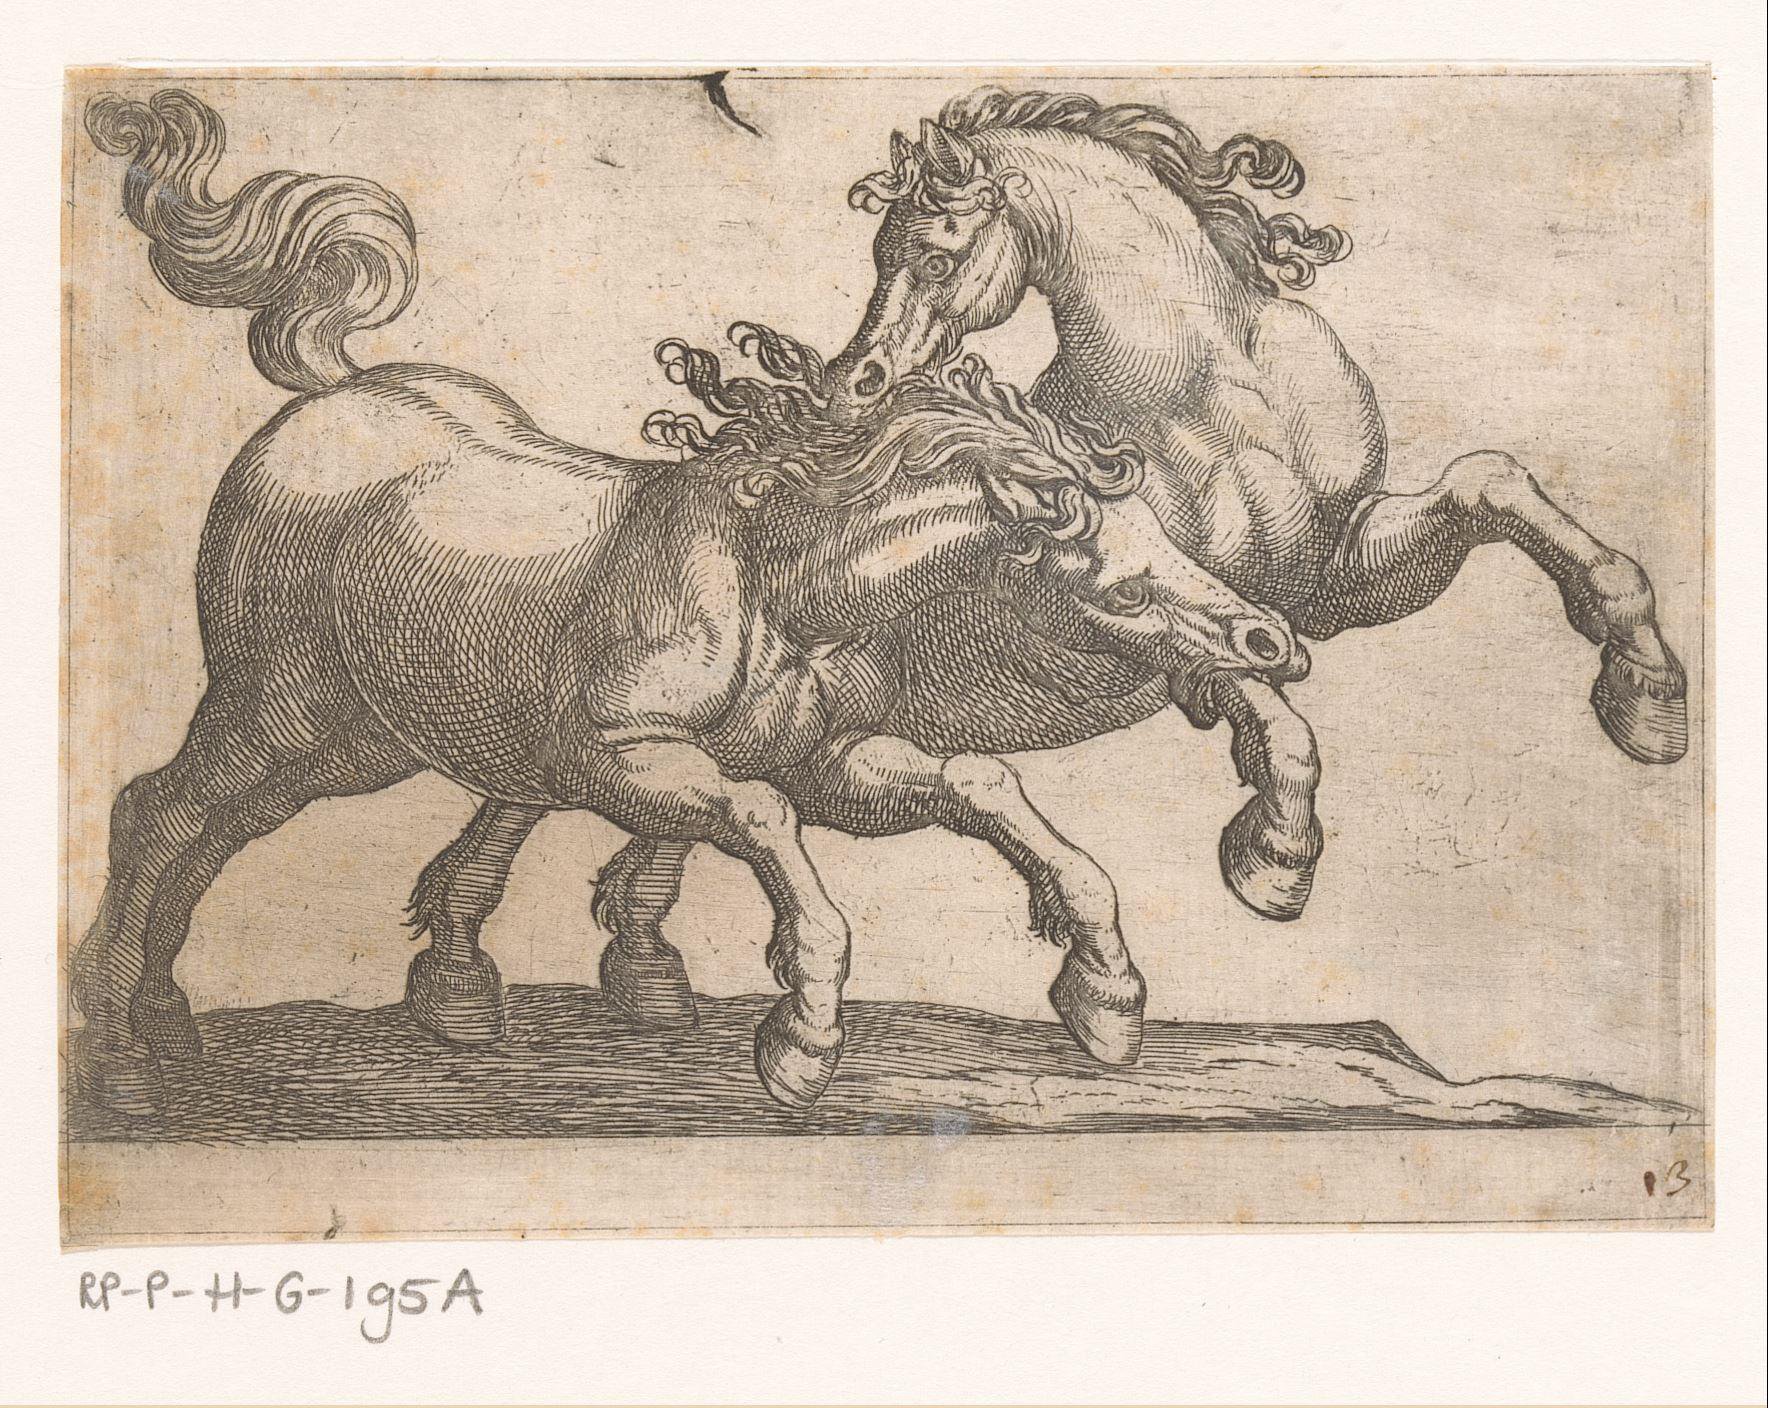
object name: print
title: Vechtende dieren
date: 1600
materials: paper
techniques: etching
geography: italy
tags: horse, fighting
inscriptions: number: ‘13’, collector's mark: Lugt 2228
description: Deze prent maakt deel uit van een reeks van 25 prenten (+ titelprent) van vechtende dieren.